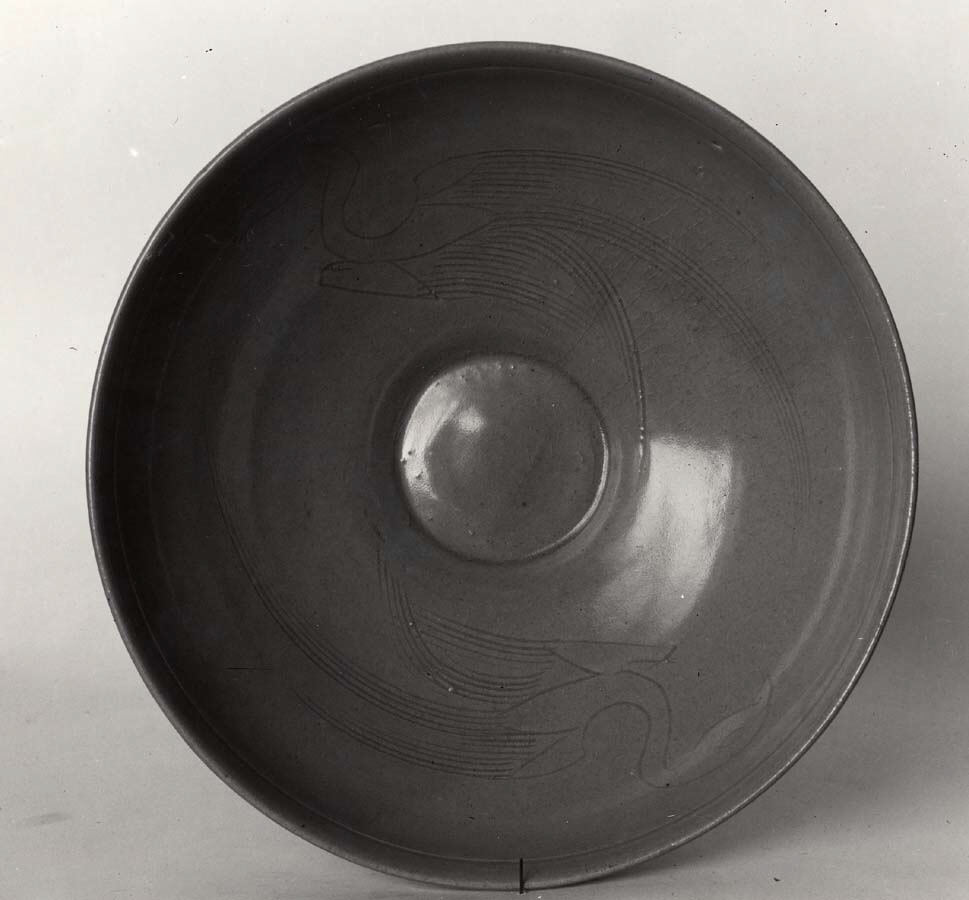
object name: bowl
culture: korean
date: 1001-1200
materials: clay